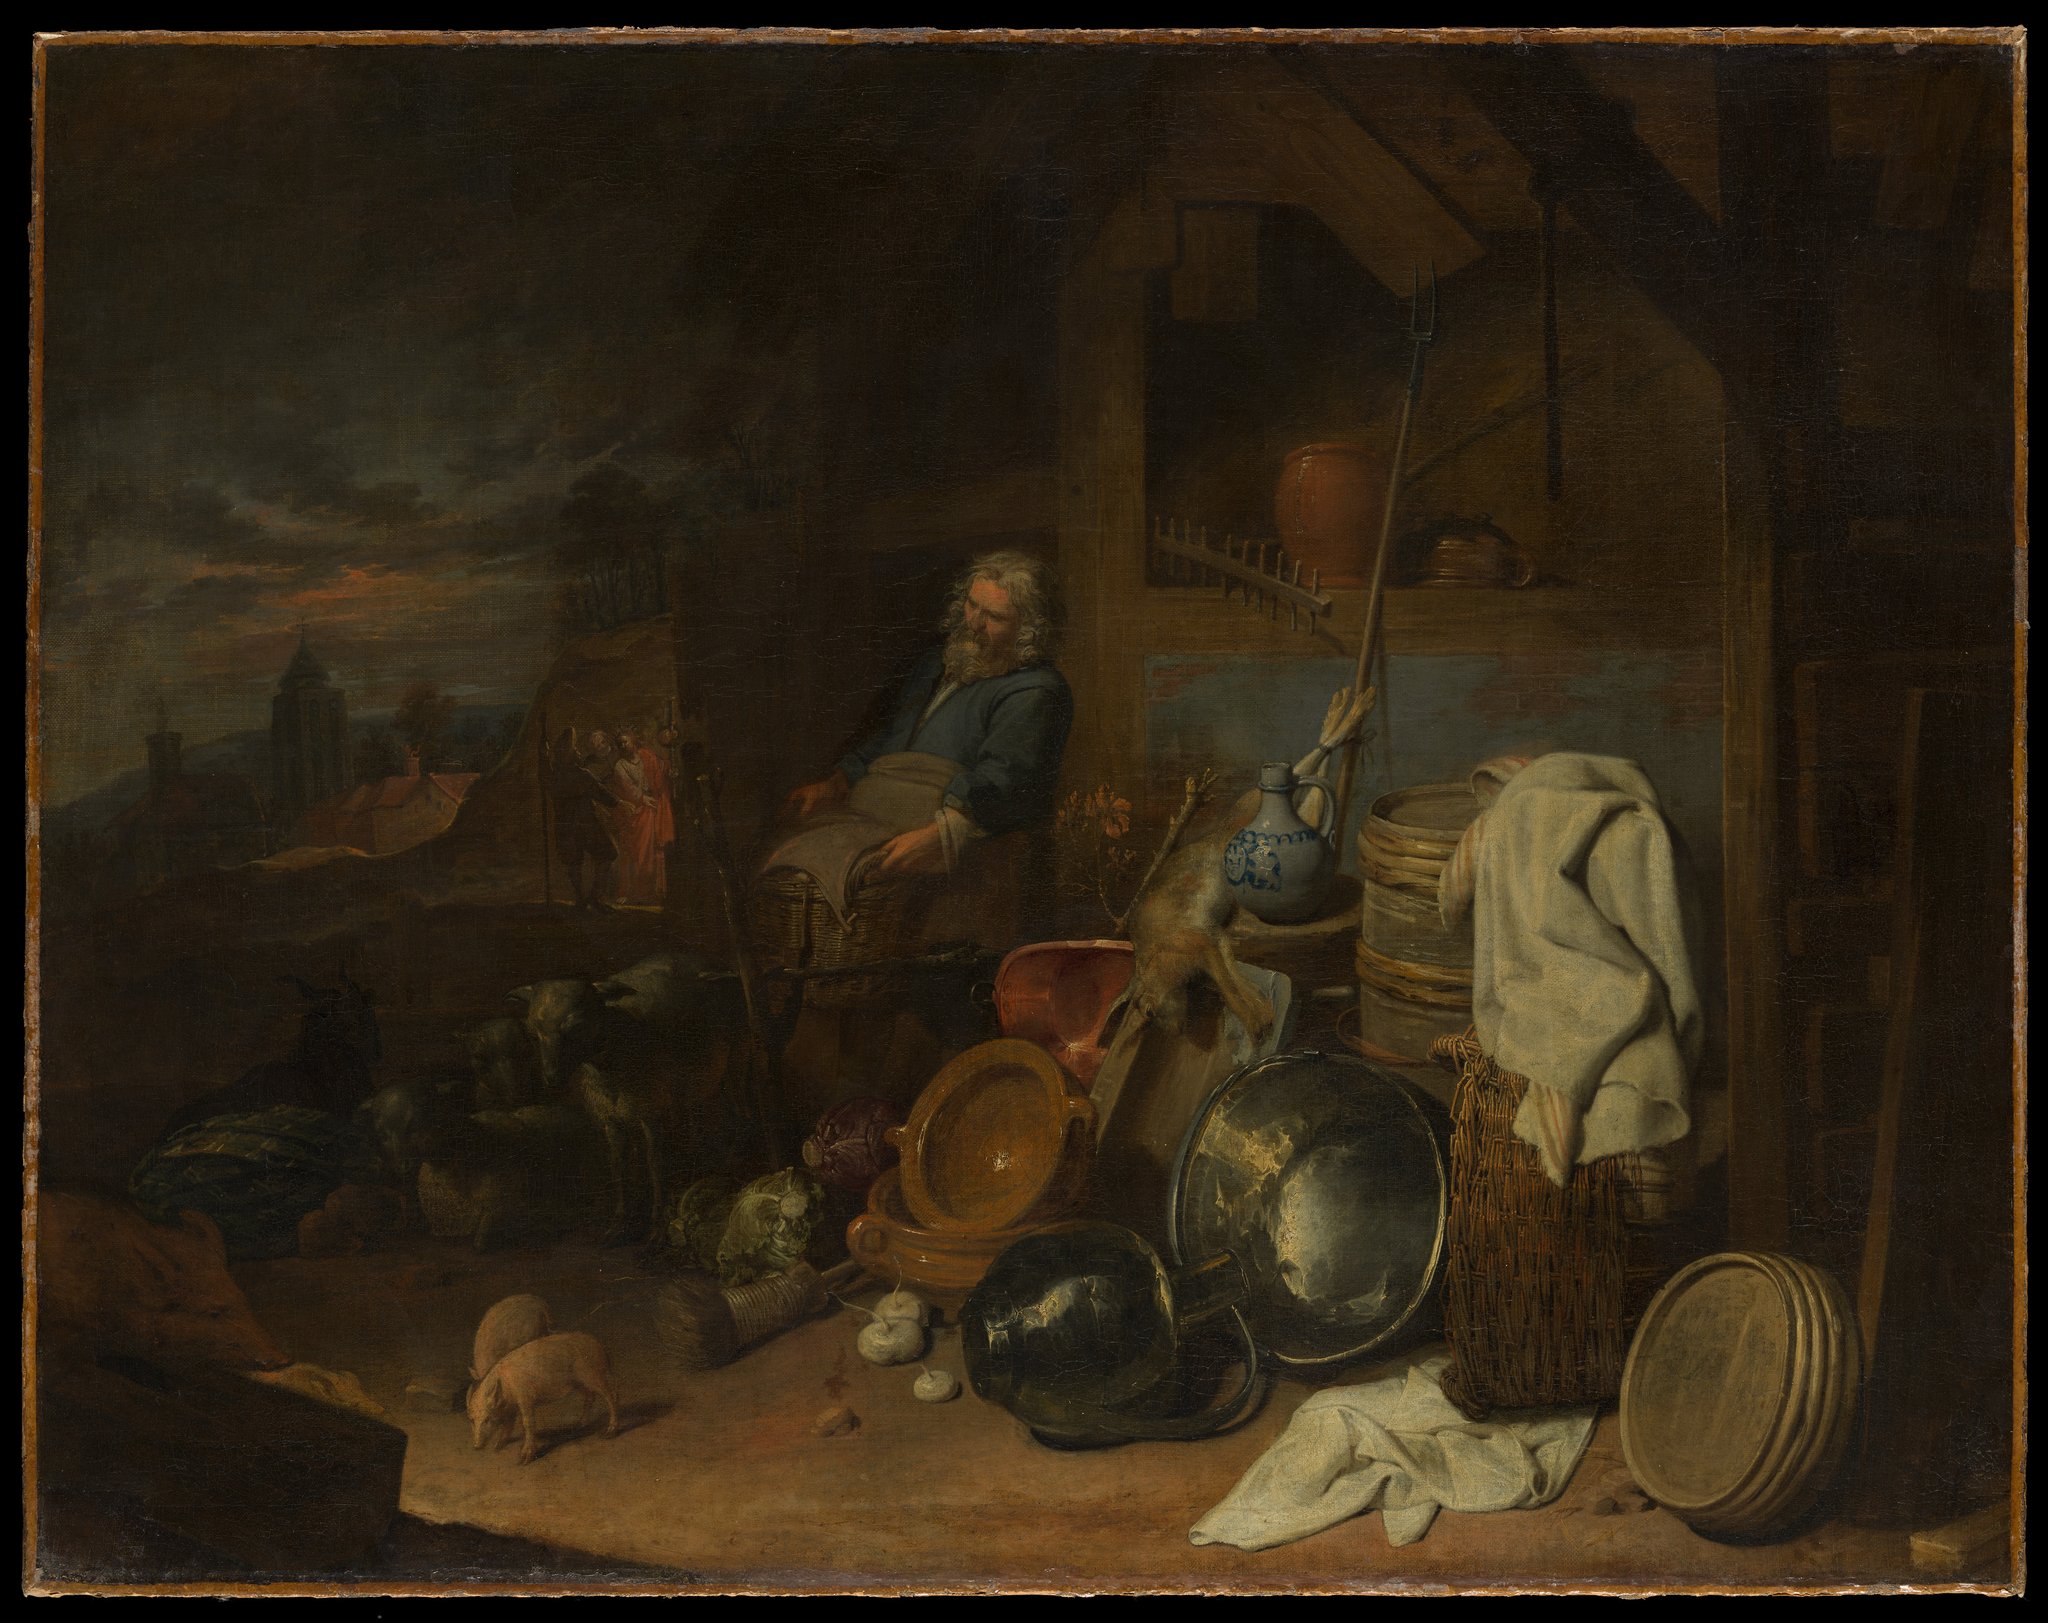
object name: painting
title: The Yard of the Inn at Emmaus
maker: david ryckaert iii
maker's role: artist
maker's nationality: flemish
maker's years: 1612-1661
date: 1632-1661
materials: canvas, oil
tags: men,pigs,rabbits